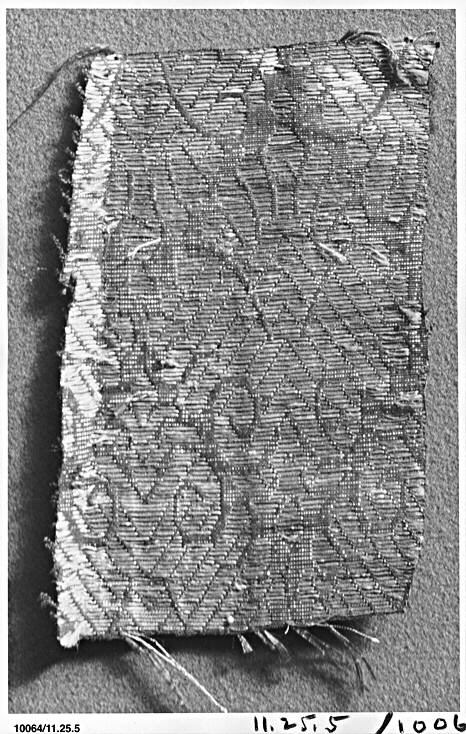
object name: fragment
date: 1501-1700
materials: metal thread, silk